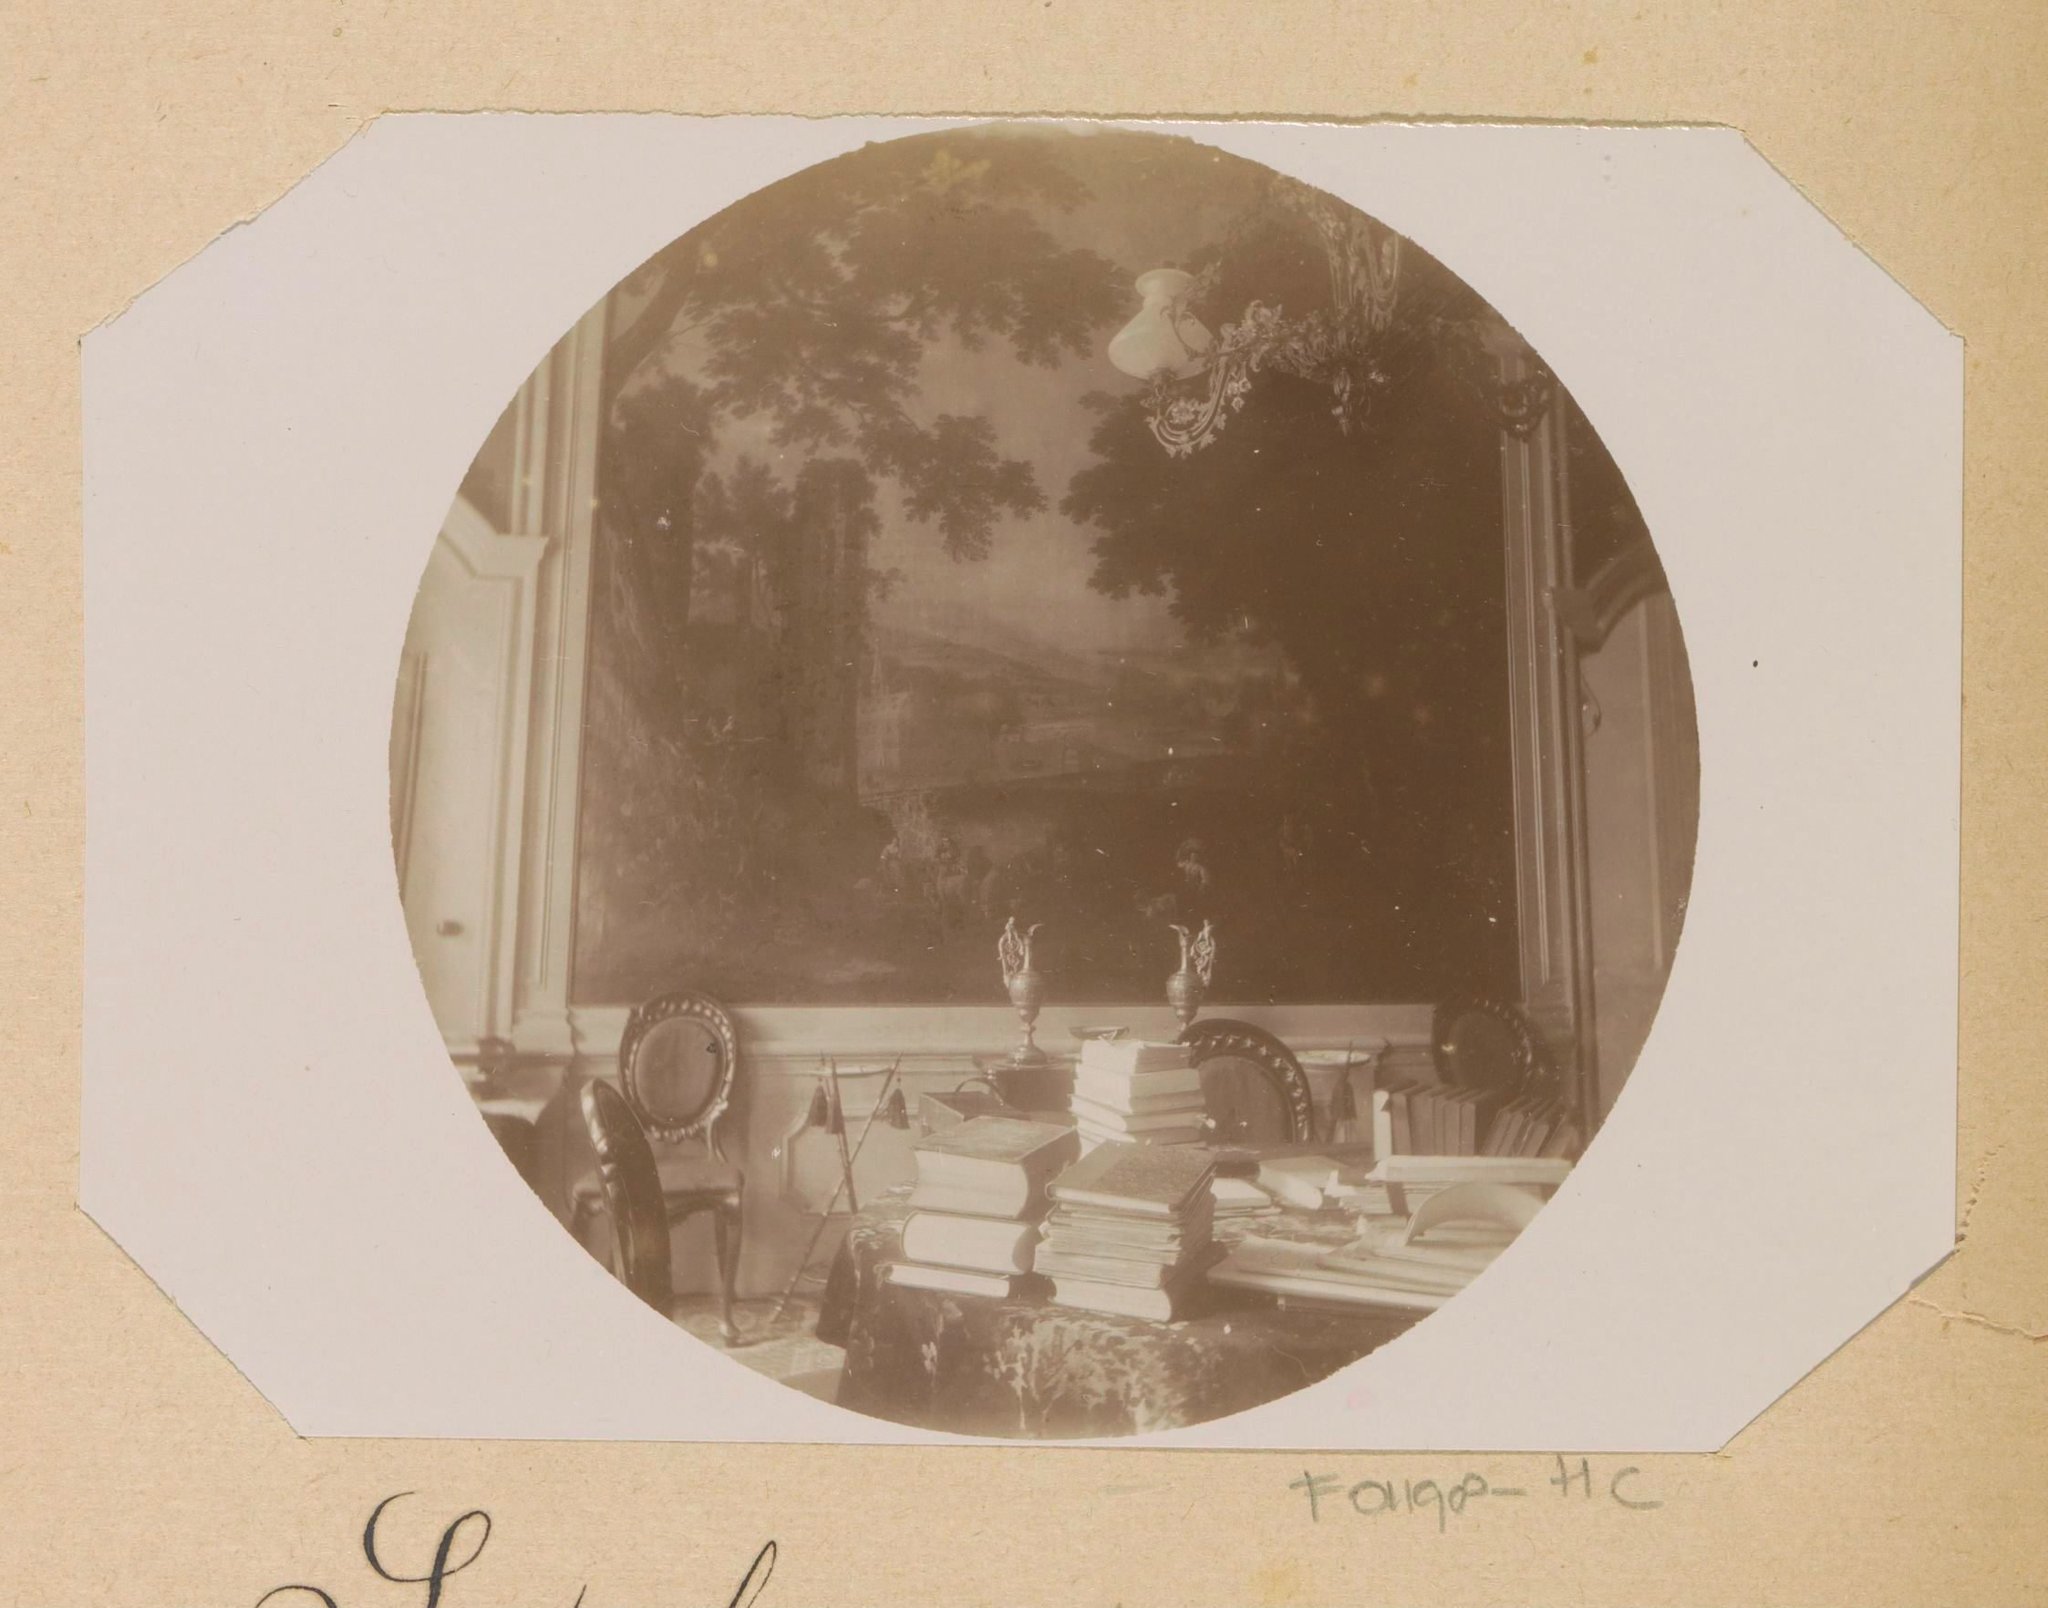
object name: album leaf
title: Muurschilderingen van Dirck Dalens III in de woning aan Herengracht 458, Amsterdam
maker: johanna margaretha piek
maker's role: fotograaf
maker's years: 1870-1947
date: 1809-1893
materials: paper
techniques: gelatin silver print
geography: amsterdam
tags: interior of the house, amsterdam